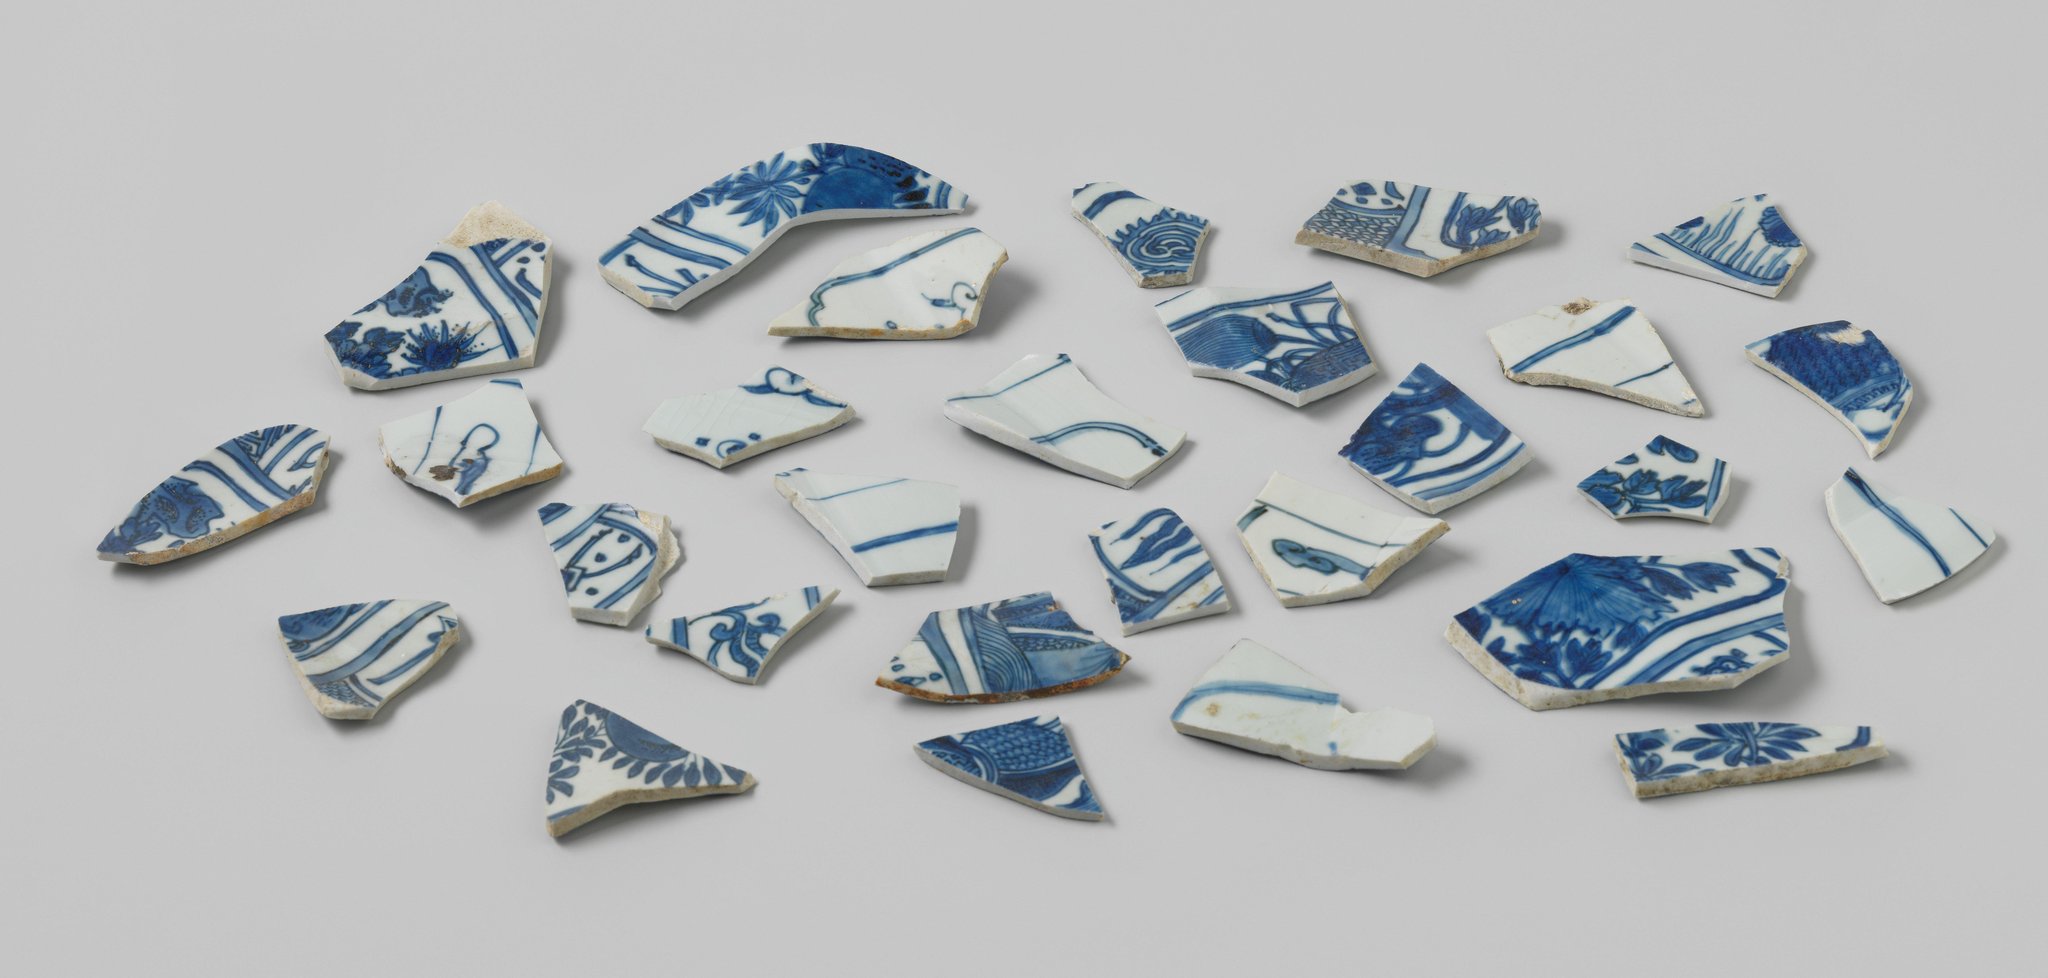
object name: plate dish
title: Scherven van borden uit V.O.C.-schip de 'Witte Leeuw'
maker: Anonymous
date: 1613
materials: bone china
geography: jingdezhen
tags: verenigde oostindische compagnie, sint-helena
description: Scherven van borden uit V.O.C.-schip de 'Witte Leeuw'.